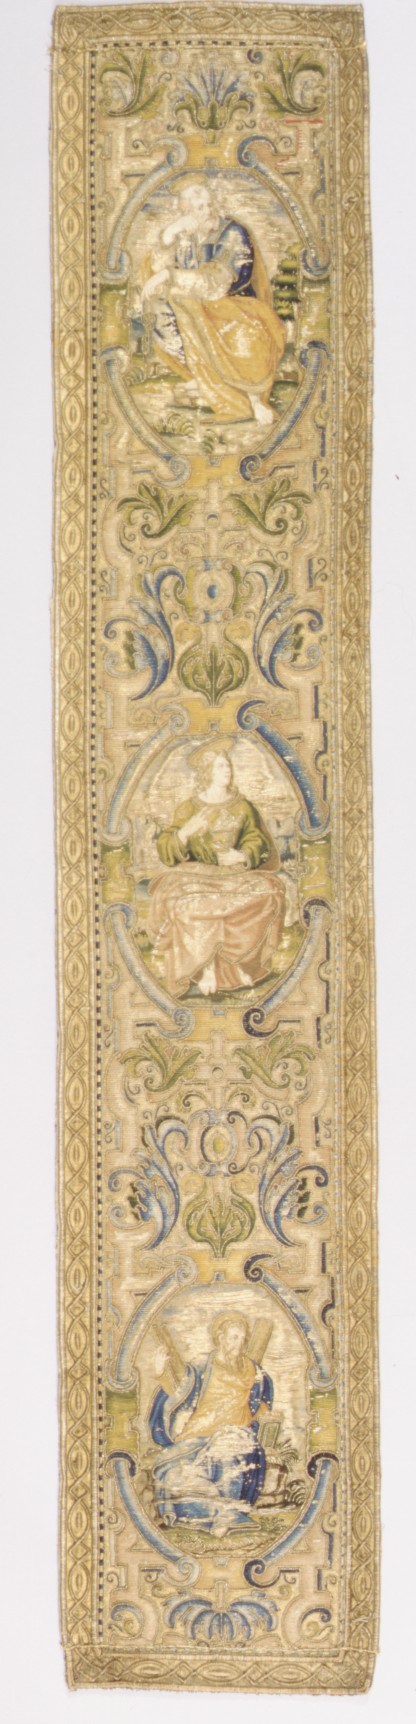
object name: orphrey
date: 1501-1600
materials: canvas, metal thread, silk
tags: men,women